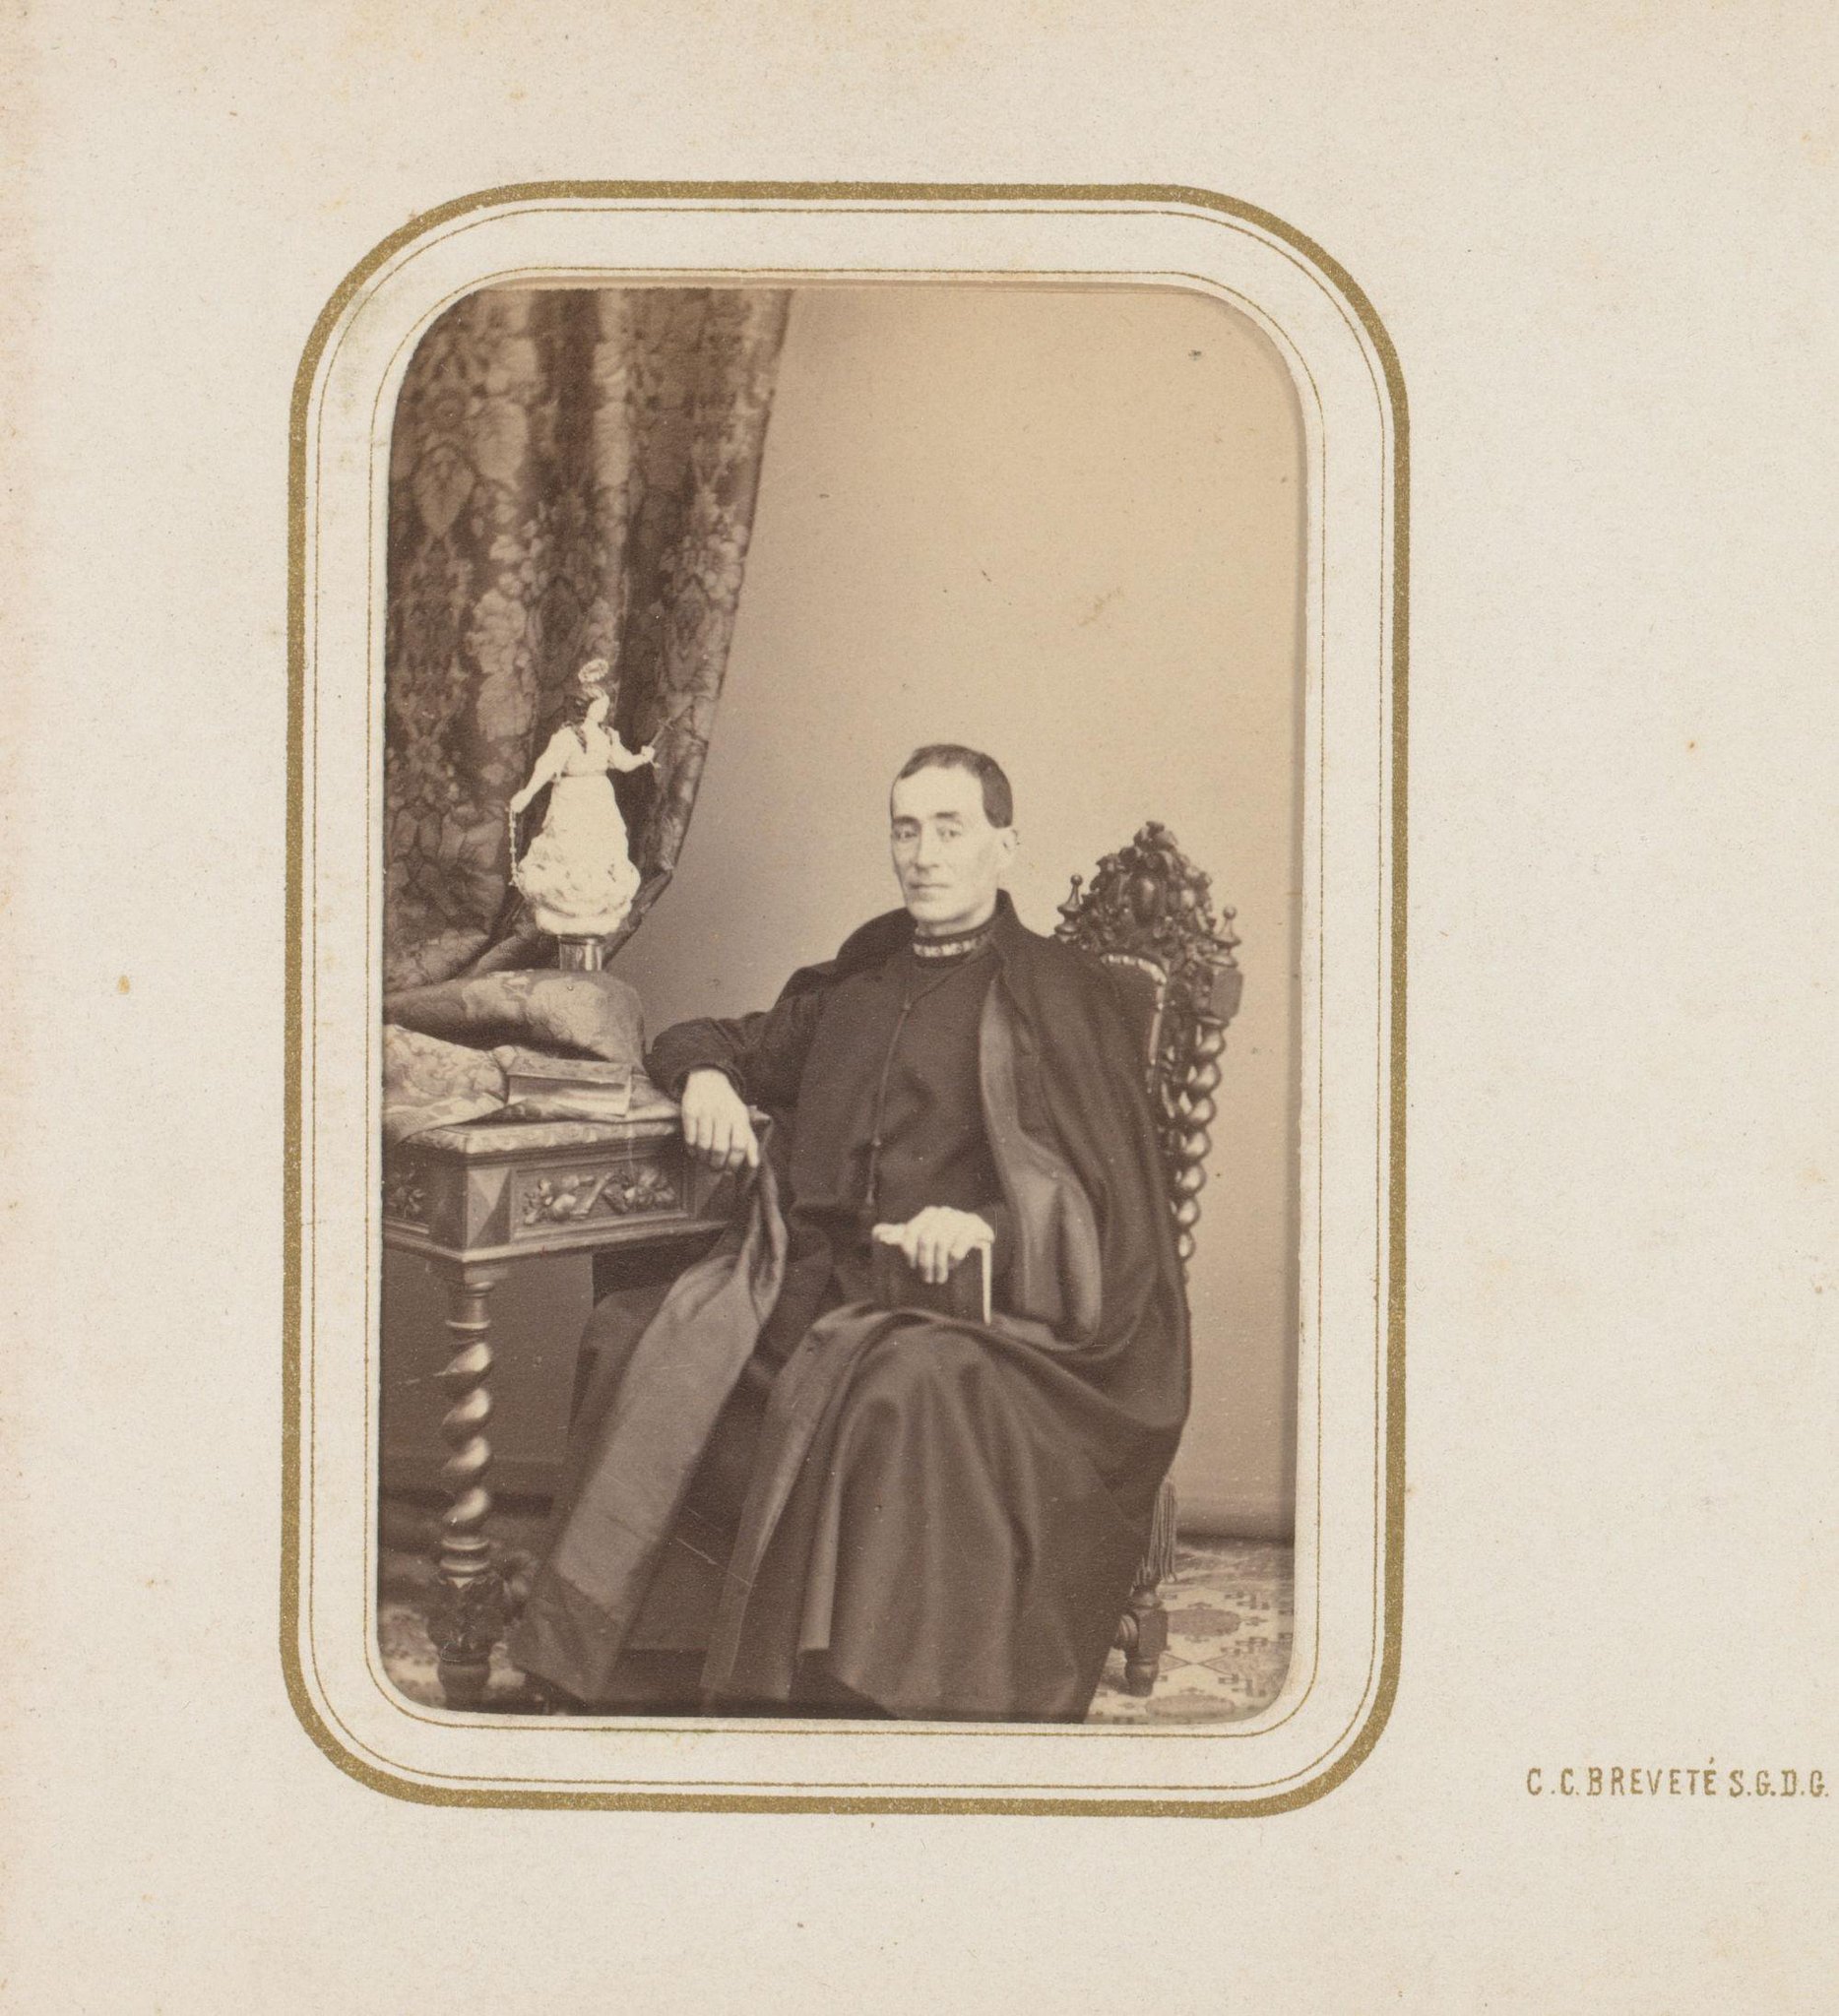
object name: album leaf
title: Portret van een geestelijke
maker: josé garcía ayola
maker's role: fotograaf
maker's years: 1836-1900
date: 1860-1900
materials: cardboard, photographic support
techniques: albumen print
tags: sitting figure, adult man, historical persons, organization, functionaries and dignitaries in churches and in related institutions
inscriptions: inscription: ‘J. G. Ayola/ Fotografo/ Calle de Lucena No 3/ Granada’